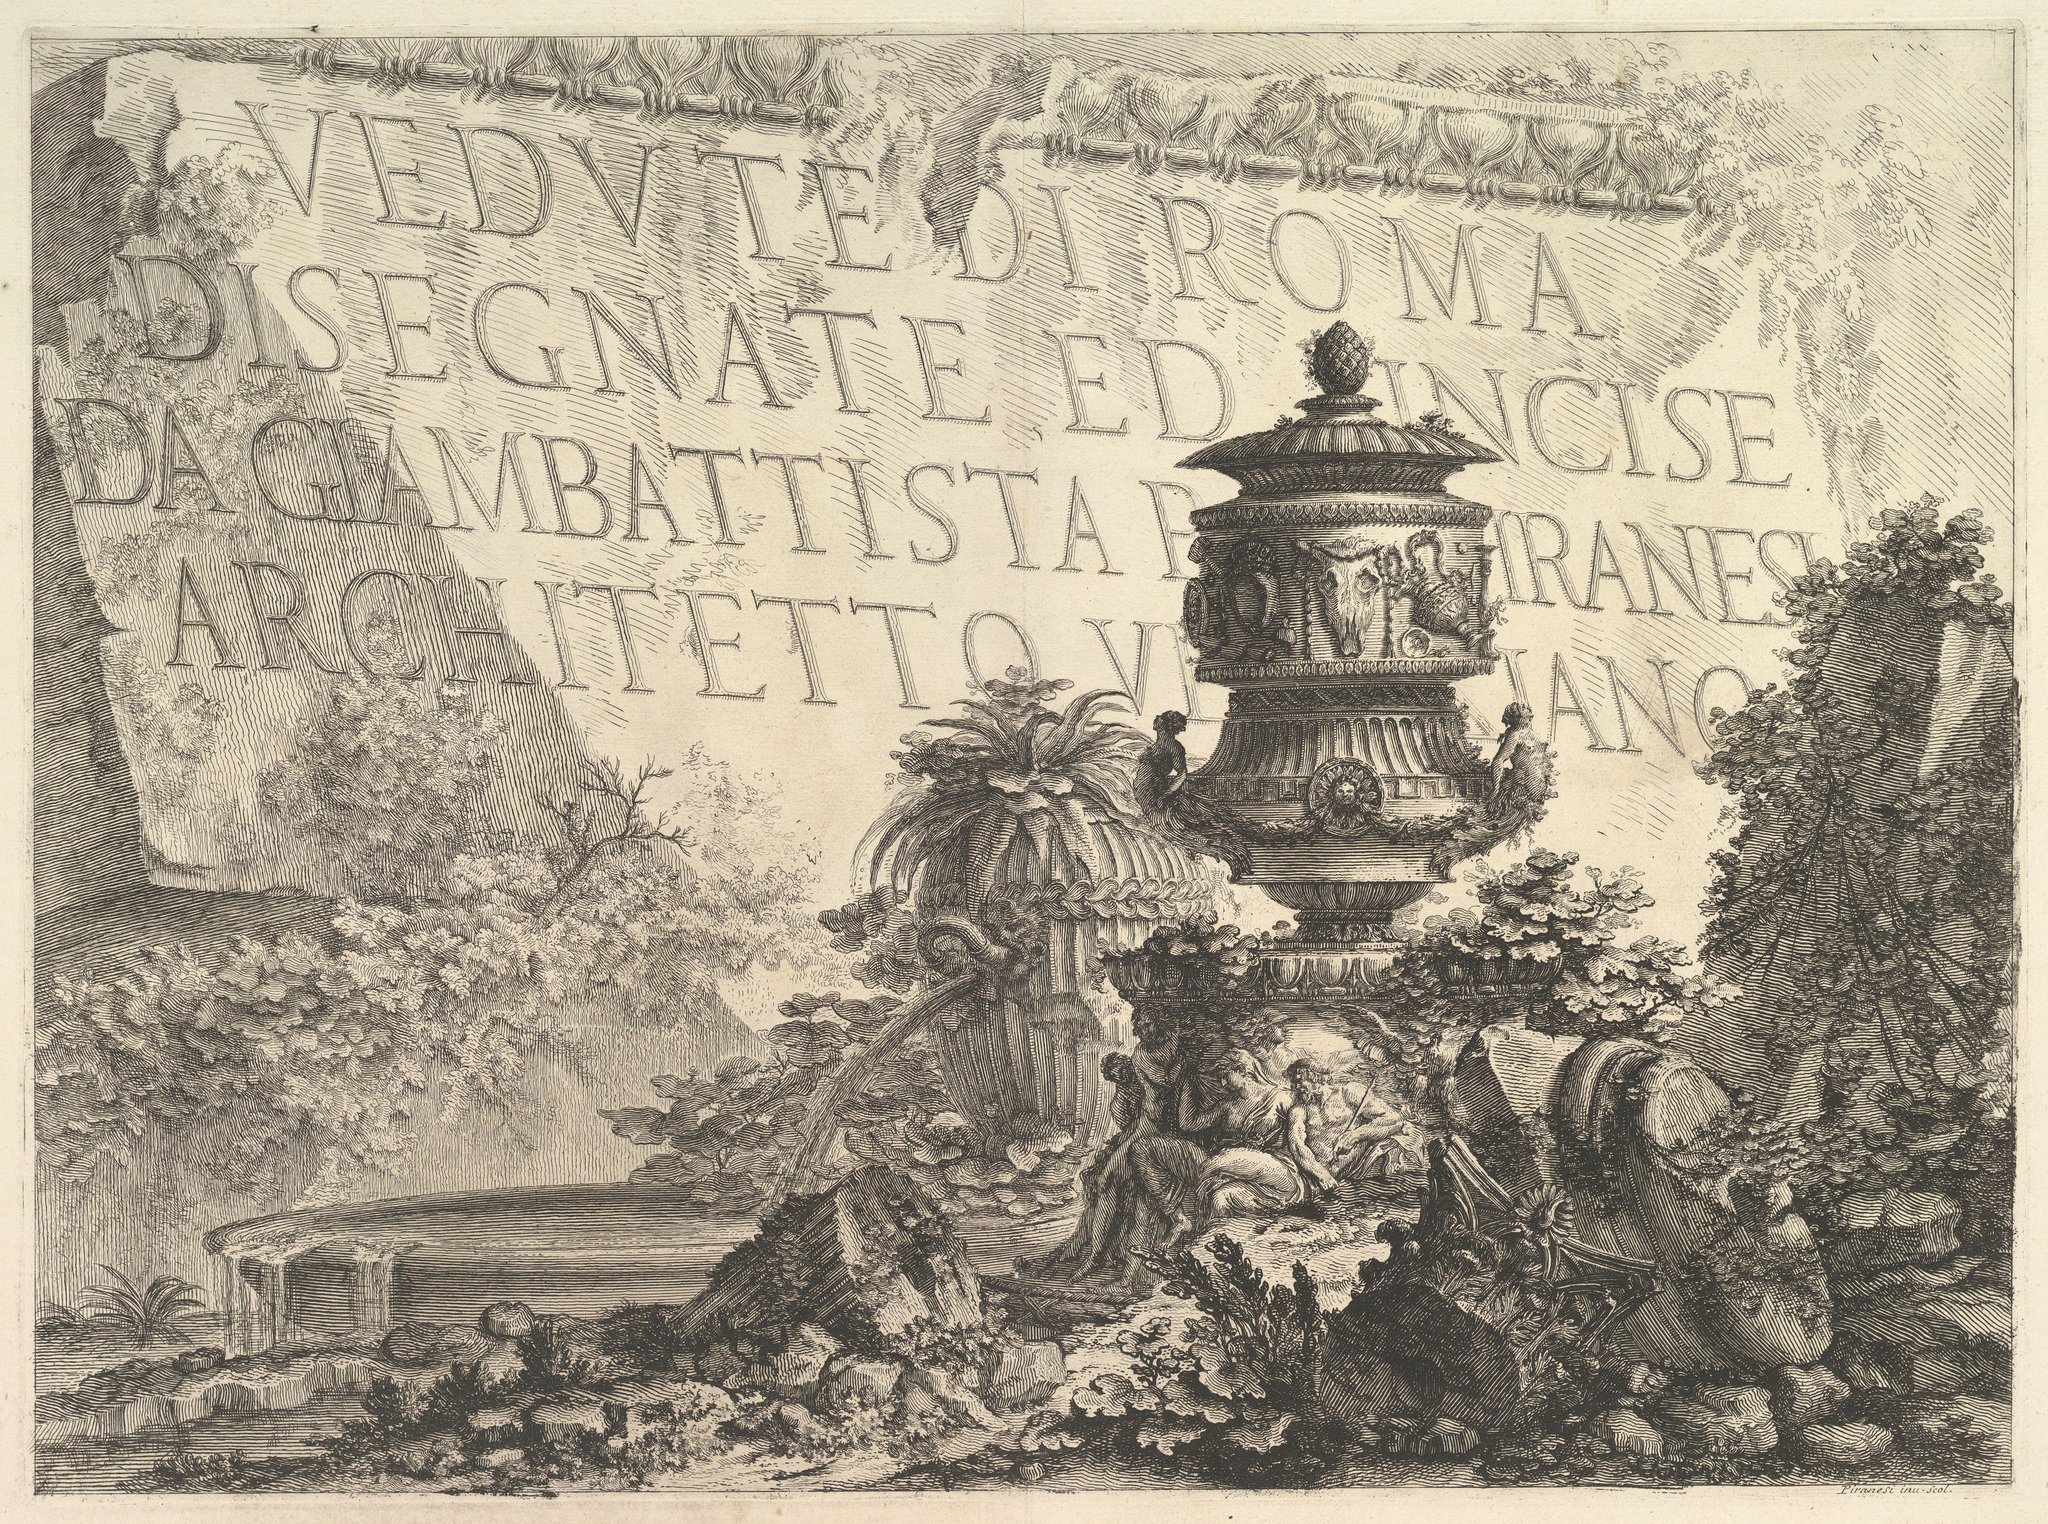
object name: print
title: Frontispiece from "Vedute di Roma"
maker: giovanni battista piranesi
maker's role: artist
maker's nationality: italian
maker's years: 1720-1778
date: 1748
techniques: etching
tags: human figures,sculpture,fountains